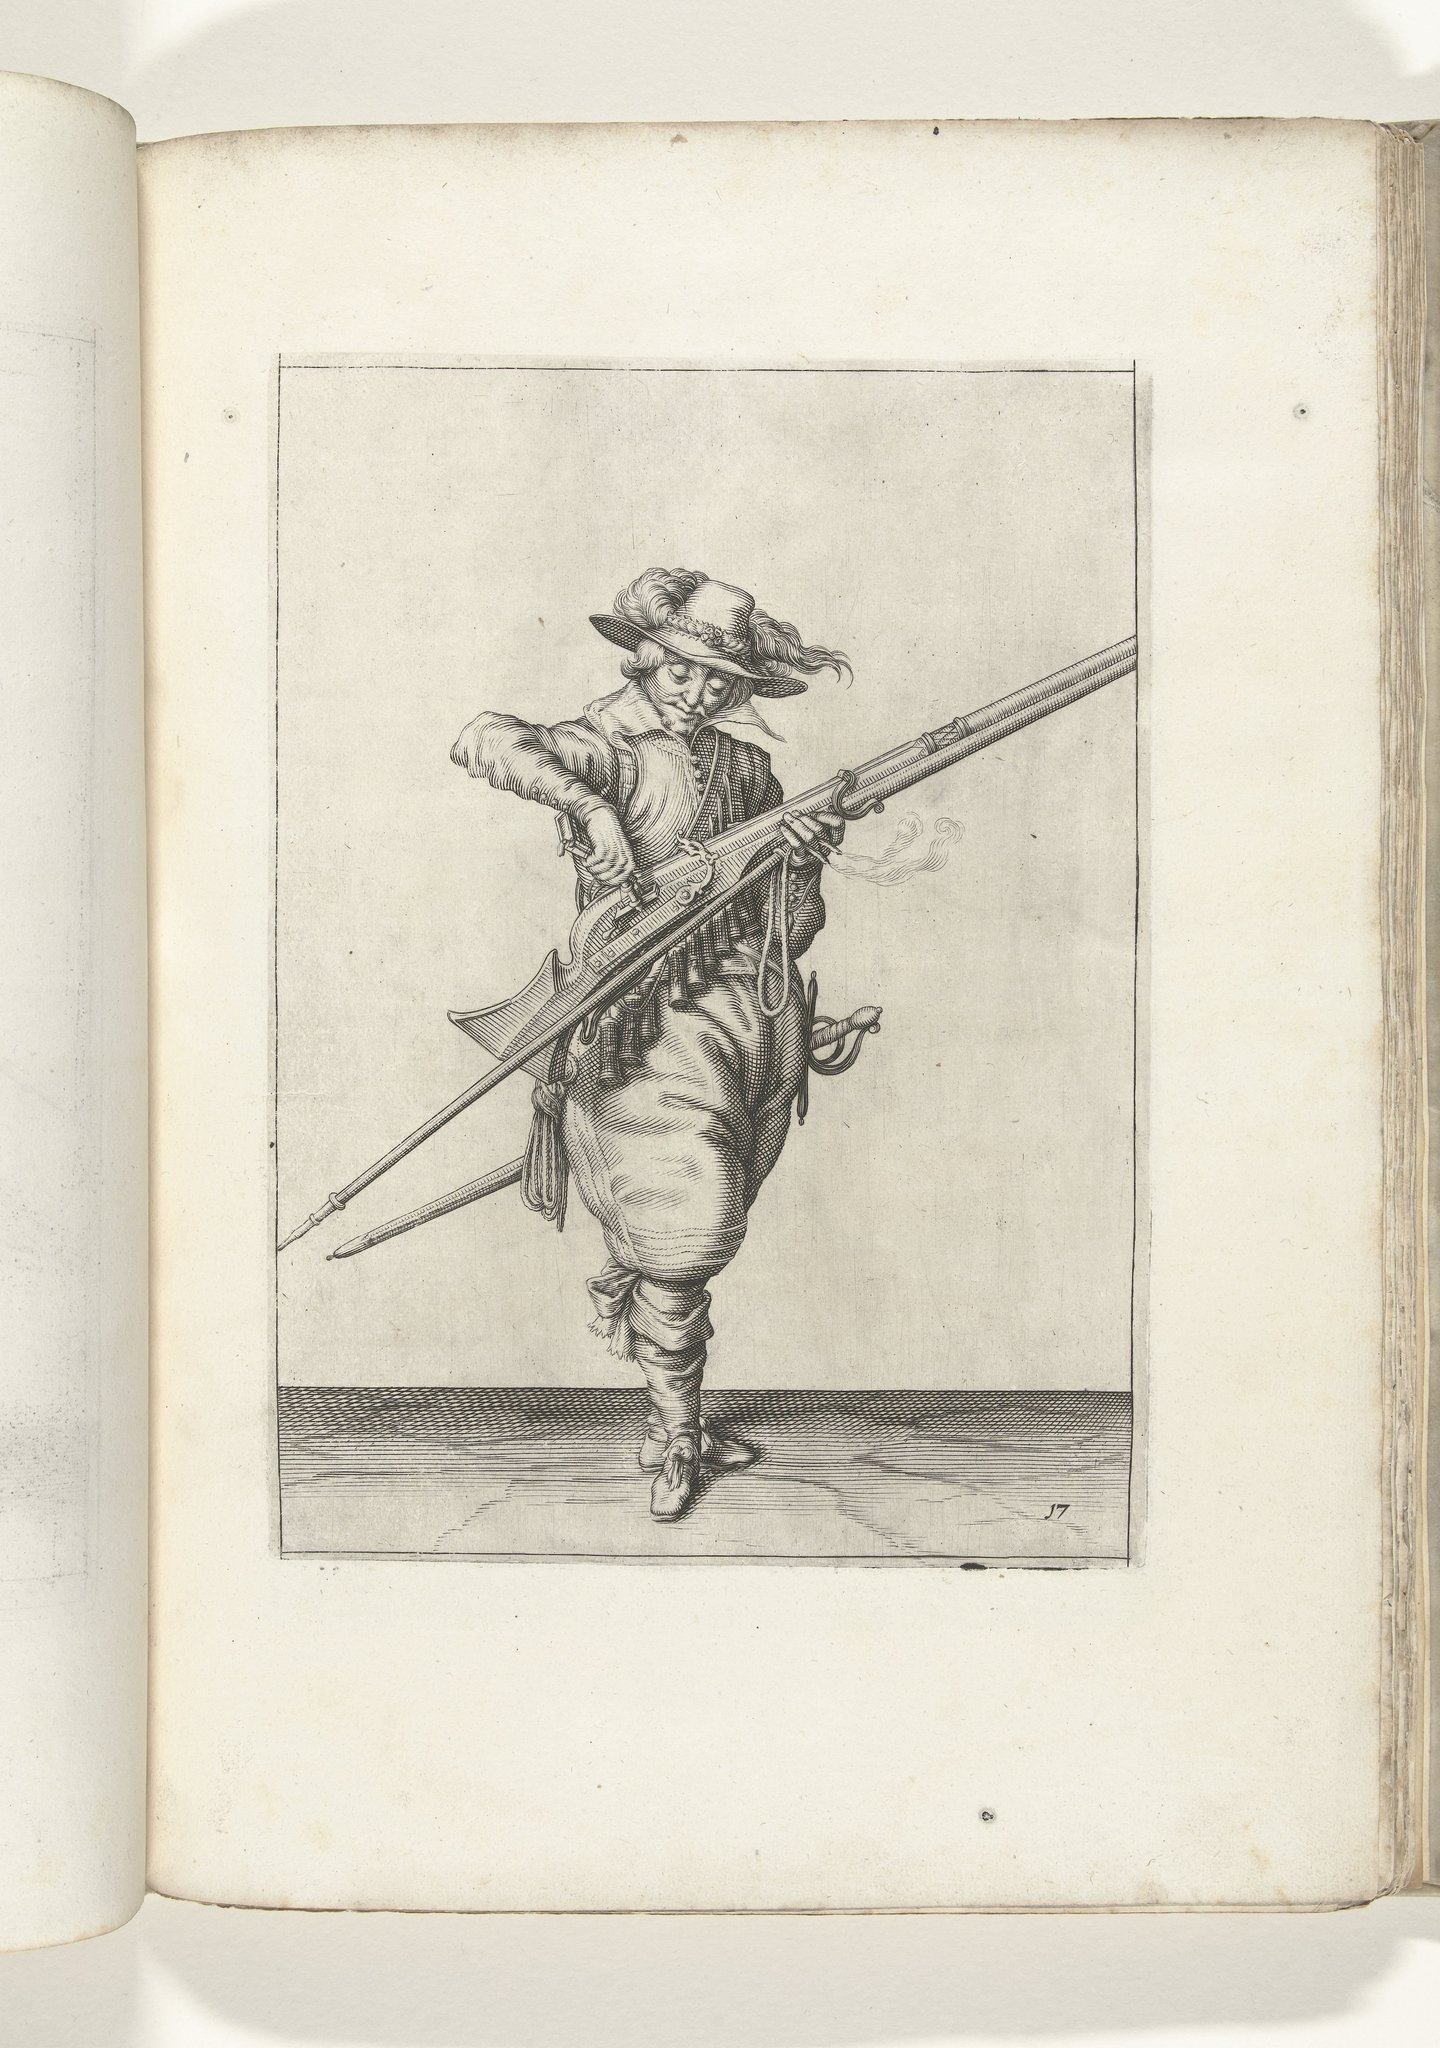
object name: print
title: Soldaat die kruit in de pan van zijn musket giet (nr. 17), ca. 1600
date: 1597-1607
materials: paper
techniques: engraving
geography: northern netherlands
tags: maurice (prince of orange), handling of weapons ~ military training, weapons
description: Een soldaat, ten voeten uit, die kruit uit een kruitfles in de pan (het kruitreservoir) van een musket (een bepaald type vuurwapen) giet (nr. 17), ca. 1600. In zijn linkerhand behalve het musket ook een furket en een brandende lont. Plaat 17 in de instructies voor het hanteren van het musket: Corte onderrechtinghe op de figuerliicke afbeeldinghe, soo veel aengaet het recht ghebruyck vant Musquet. Onderdeel van de illustraties in: J. de Gheyn, Wapenhandelinghe van Roers Musquetten ende spiessen, 's-Gravenhage, 1607. Krijgswezen rond 1600.